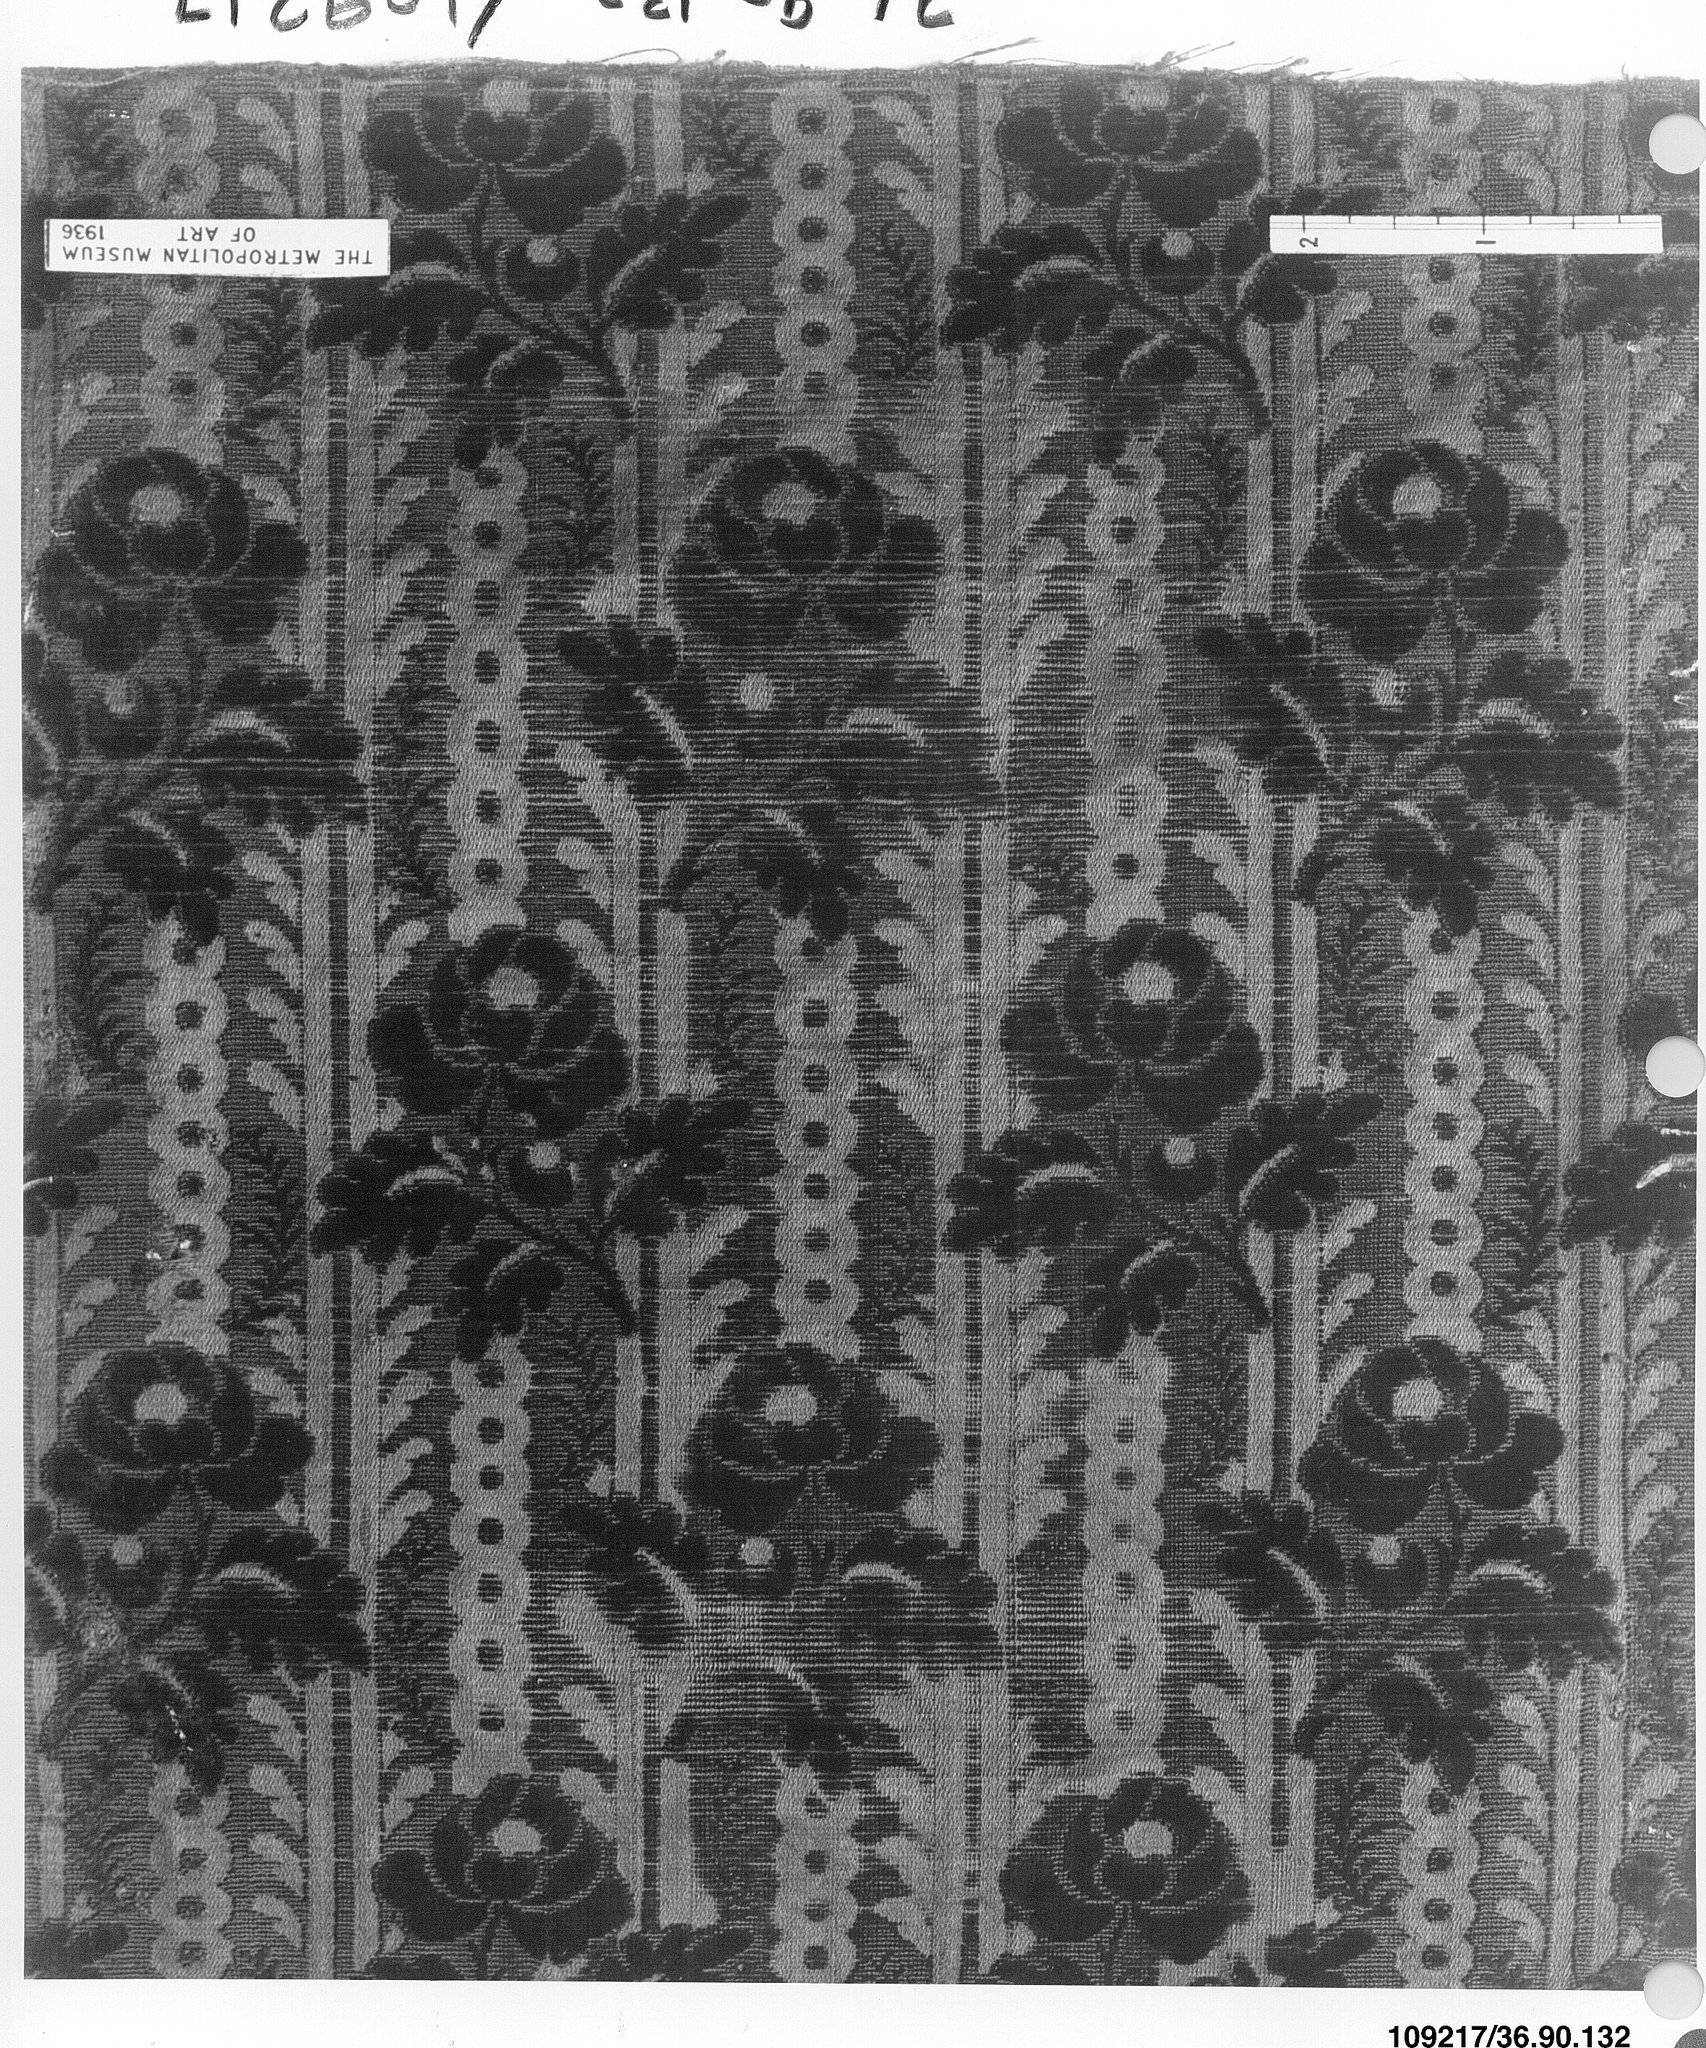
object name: piece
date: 1767-1800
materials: silk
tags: flowers,leaves